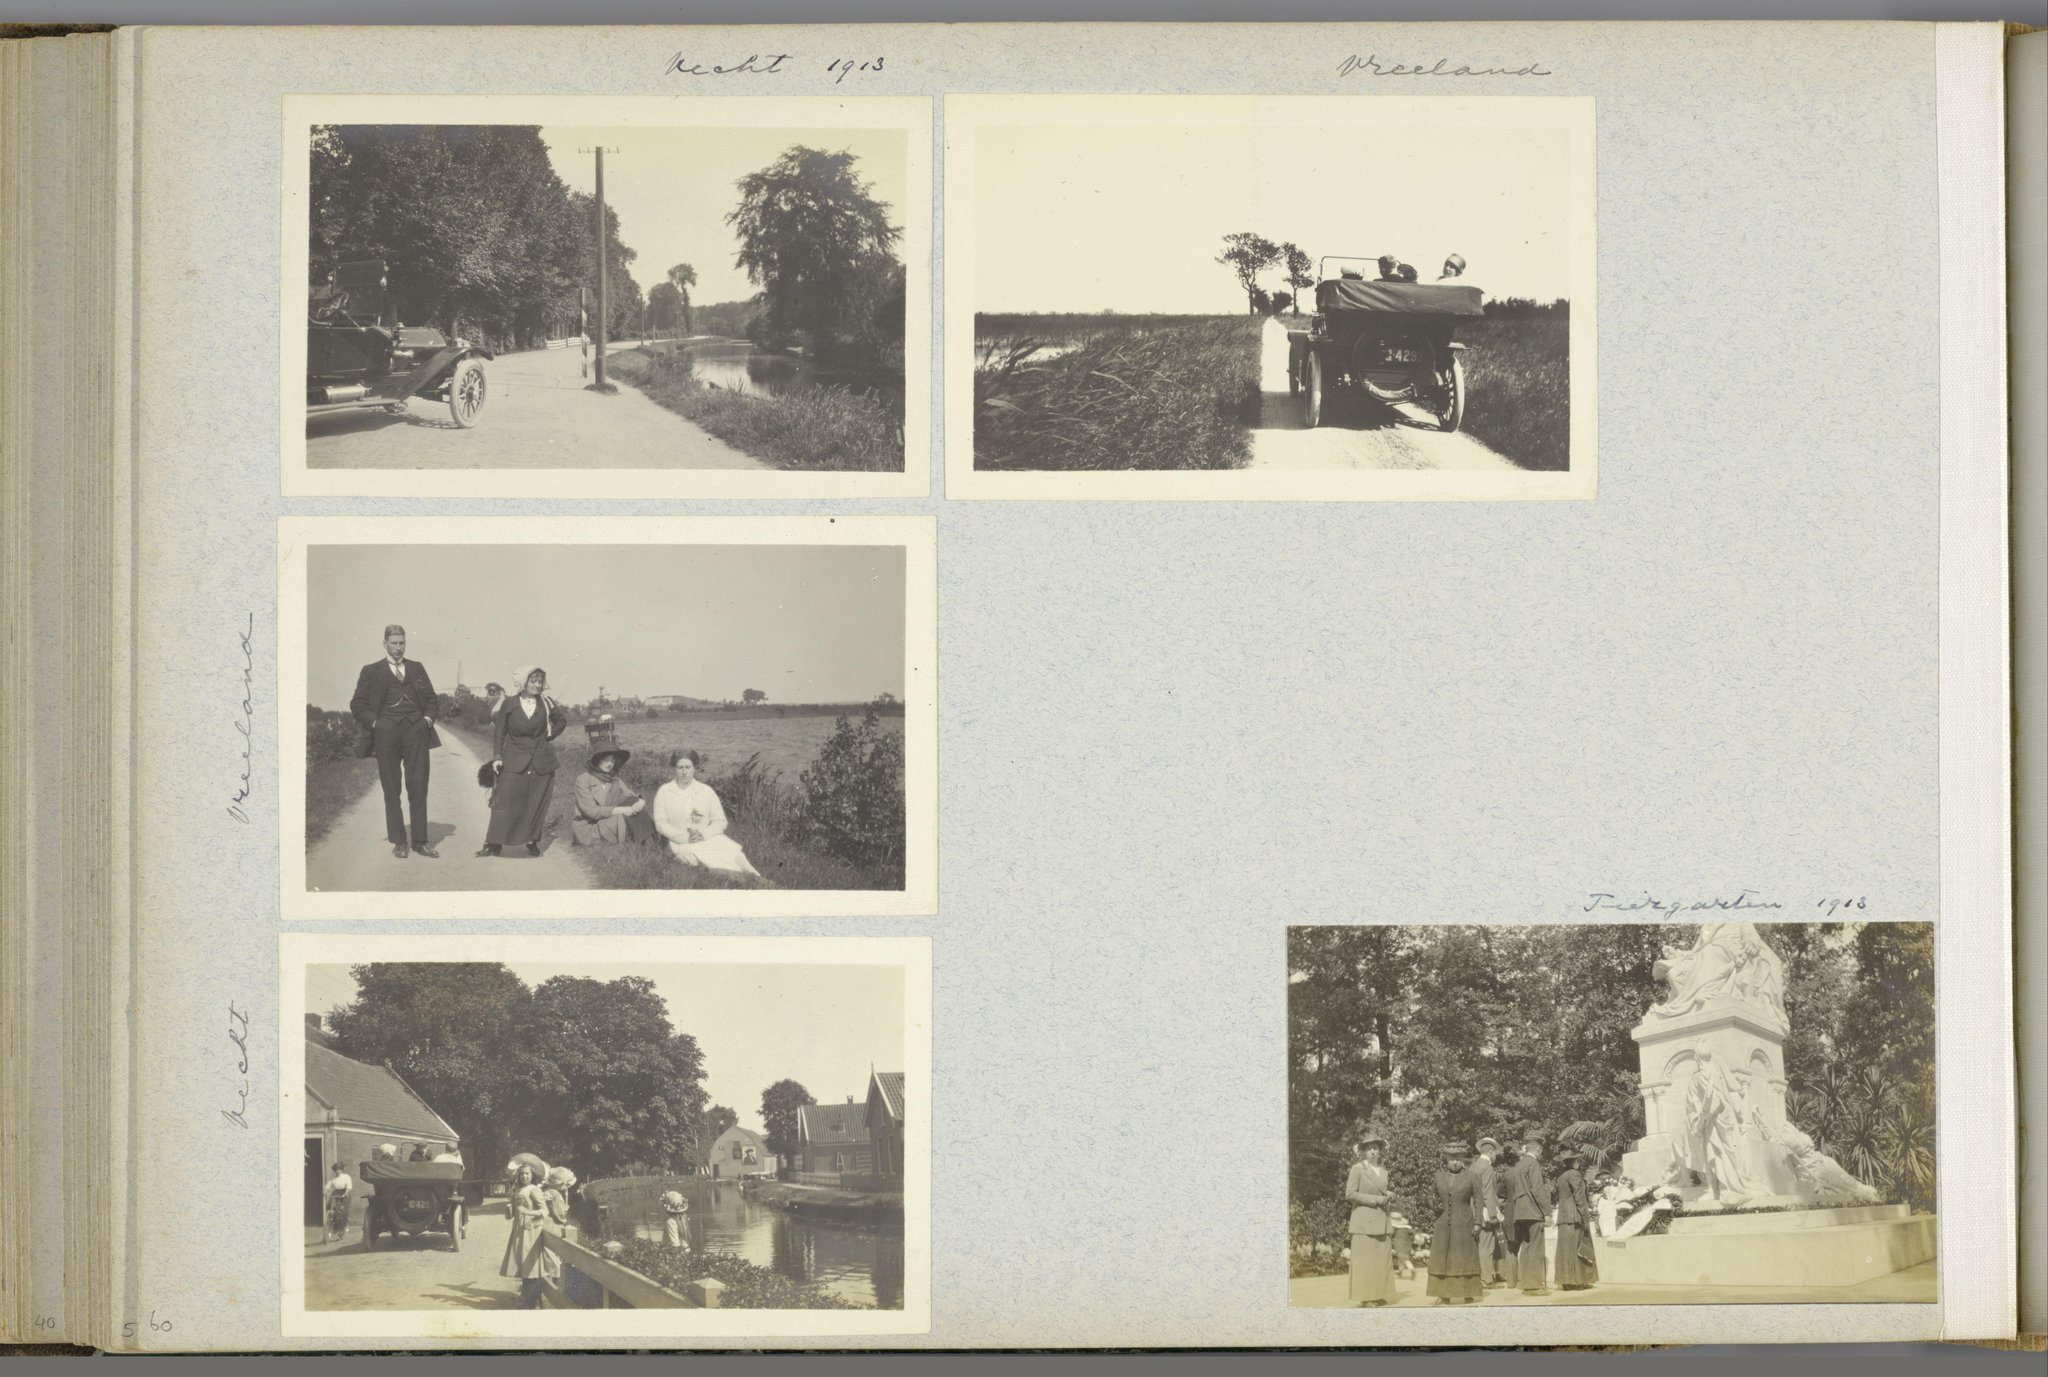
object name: album leaf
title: Albumblad met vijf foto's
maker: andries augustus boom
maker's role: amateurfotograaf, handelaar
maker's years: 1878-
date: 1913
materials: paper, photographic support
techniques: photography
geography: netherlands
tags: andries augustus boom, vecht, berlin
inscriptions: date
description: Albumblad met vijf foto's in Nederland, o.a. de Vecht en Vreeland en Tiergarten in Berlijn, 1913. Onderdeel van het fotoalbum van de familie Boom-Gonggrijp in Suriname en Curaçao.